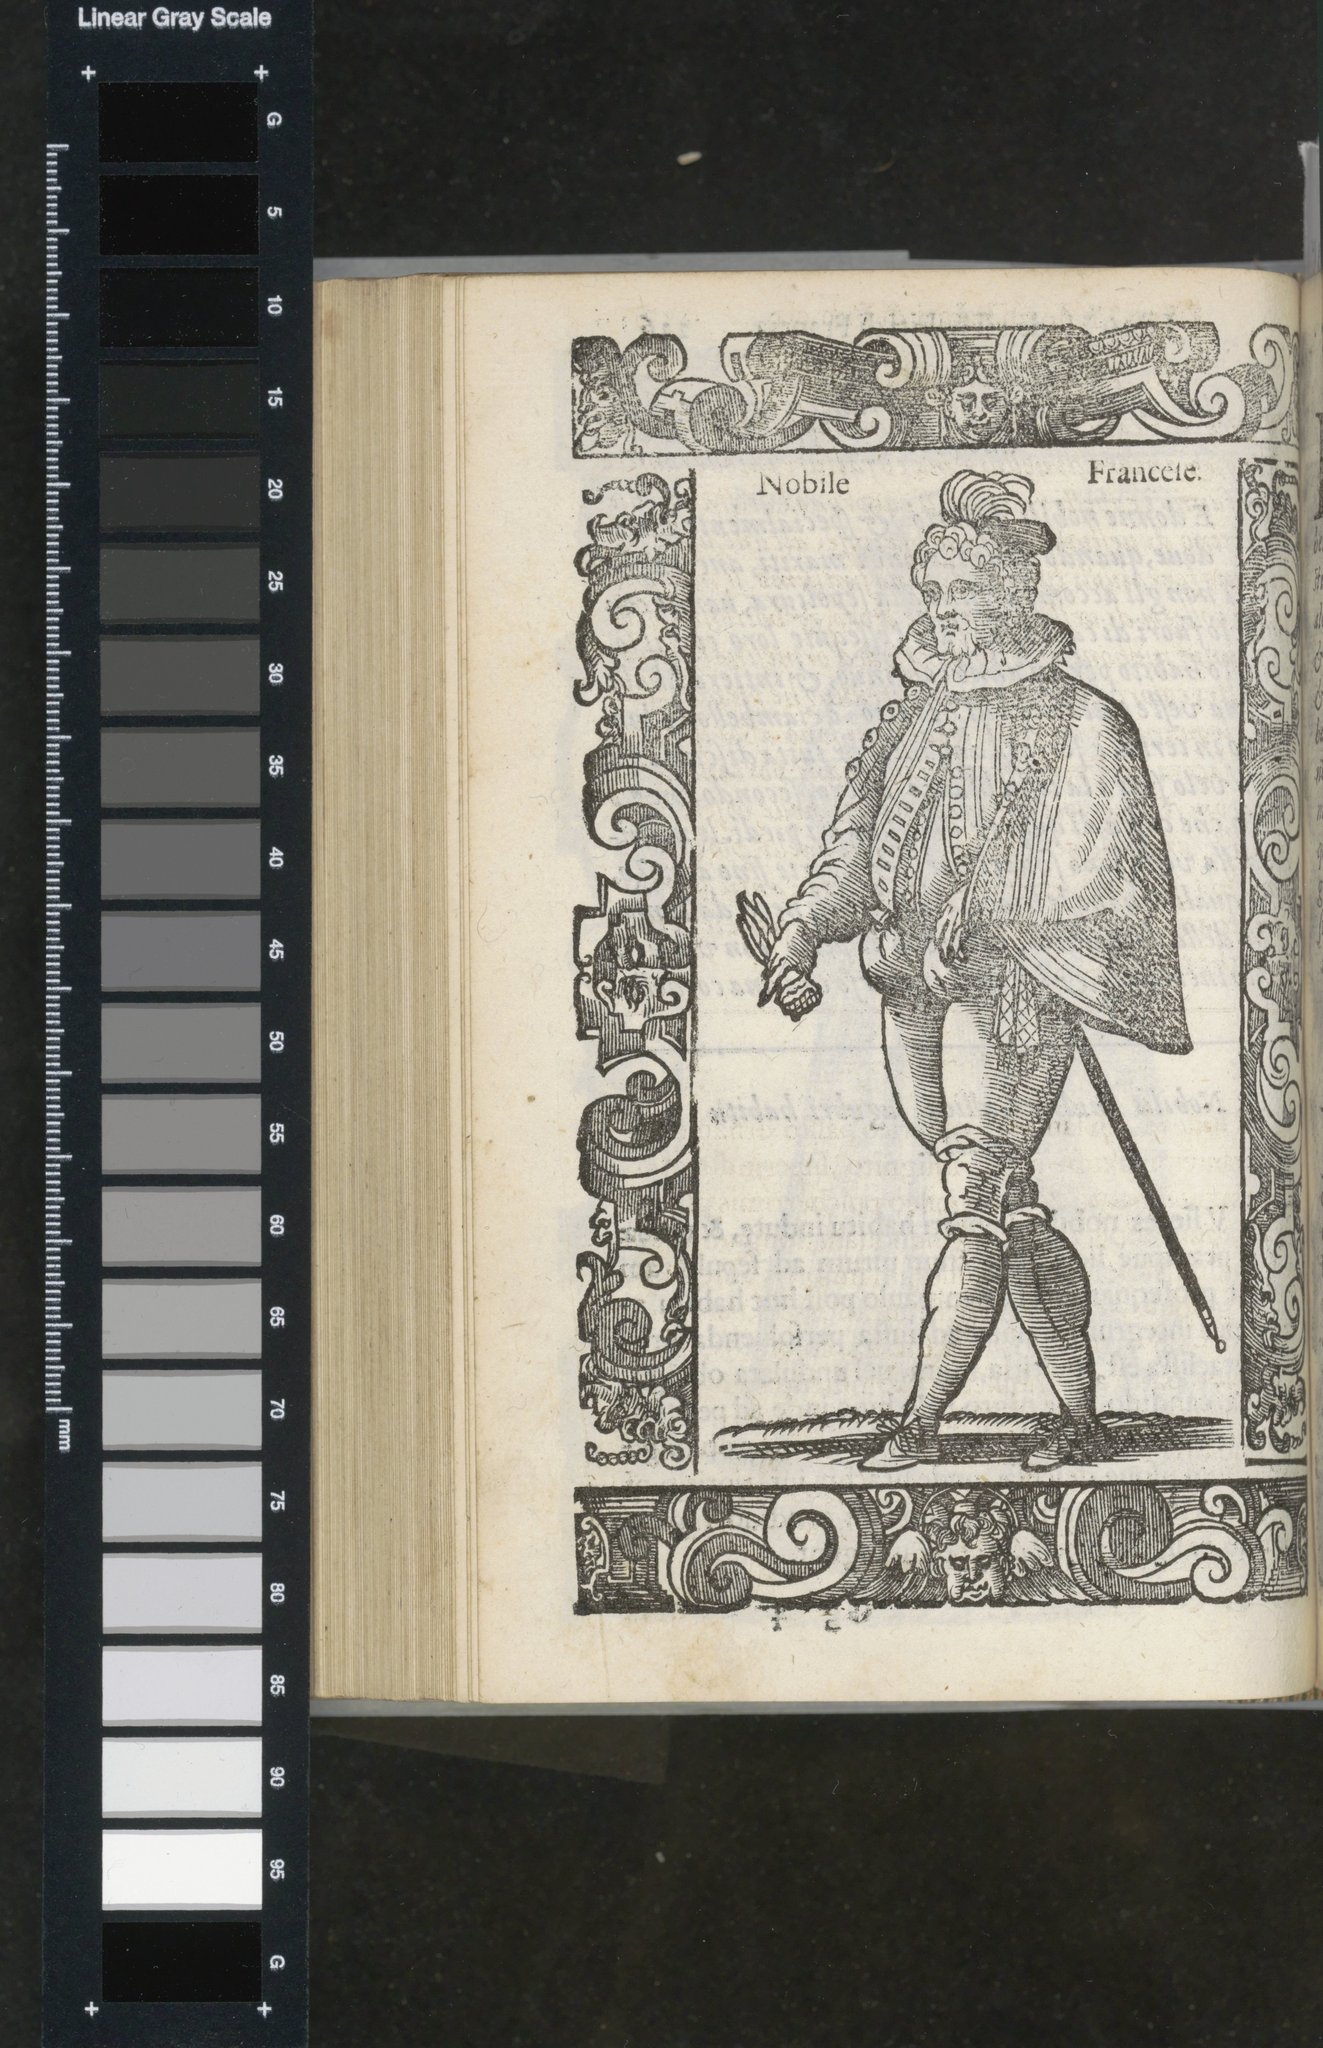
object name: costume print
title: Habiti antichi, et moderni di tutto il mondo...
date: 1598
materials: paper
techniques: woodcut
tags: fashion plates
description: Man in korte cape van wol over wambuis met wijde mouwen. Fluwelen muts op het gekrulde haar (citaat Vecellio: de Fransen krullen hun haar)